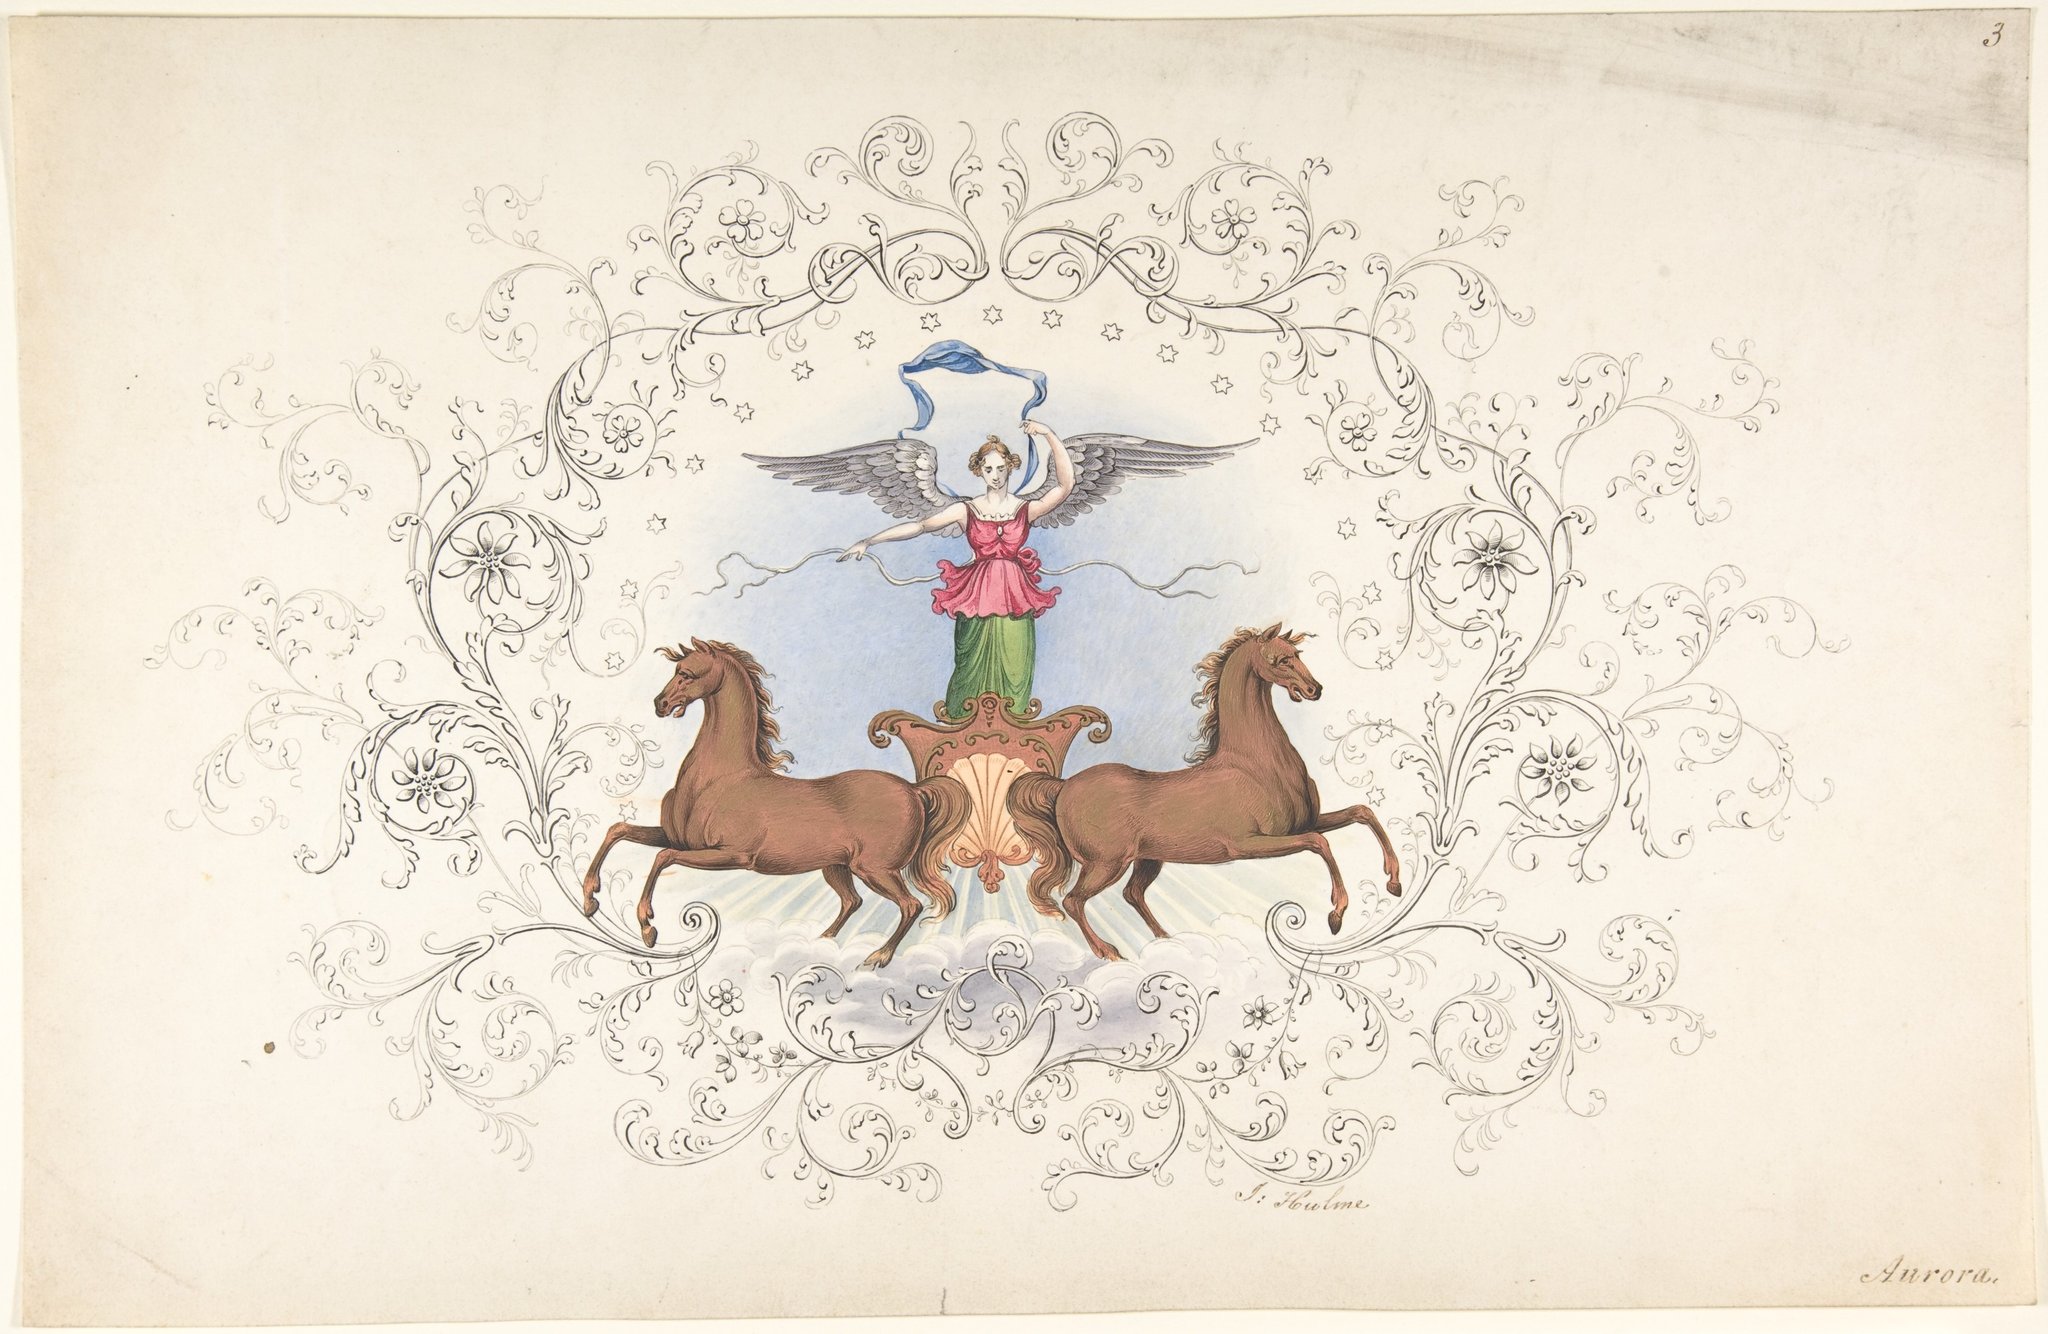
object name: drawing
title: Design for Panel Decoration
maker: j. hulme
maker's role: artist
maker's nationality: british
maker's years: 1800-1880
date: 1828-1840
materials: gold, ink, watercolor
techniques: pen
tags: ornament,horses